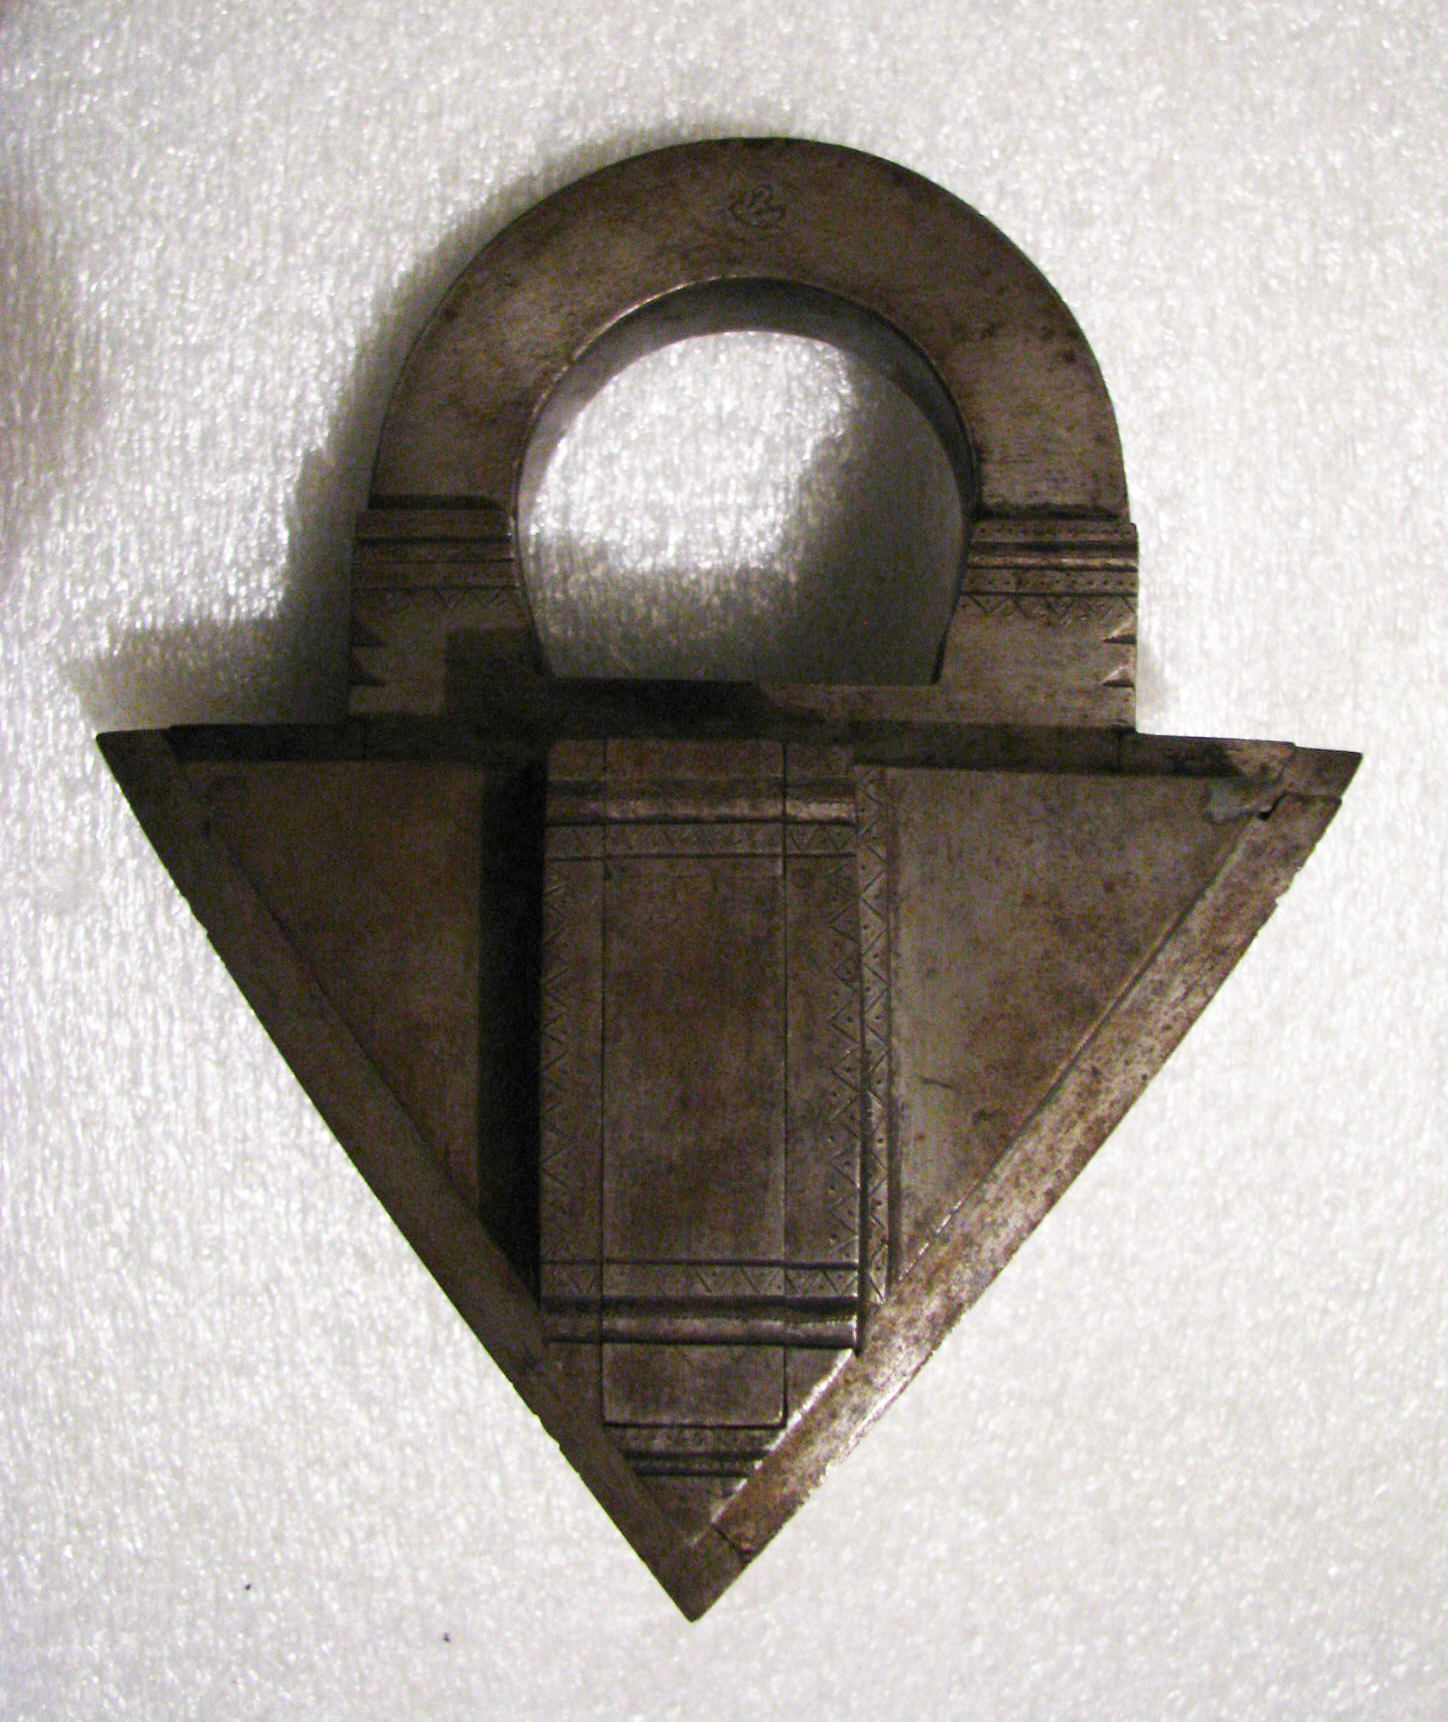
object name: padlock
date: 1801-1900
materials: iron